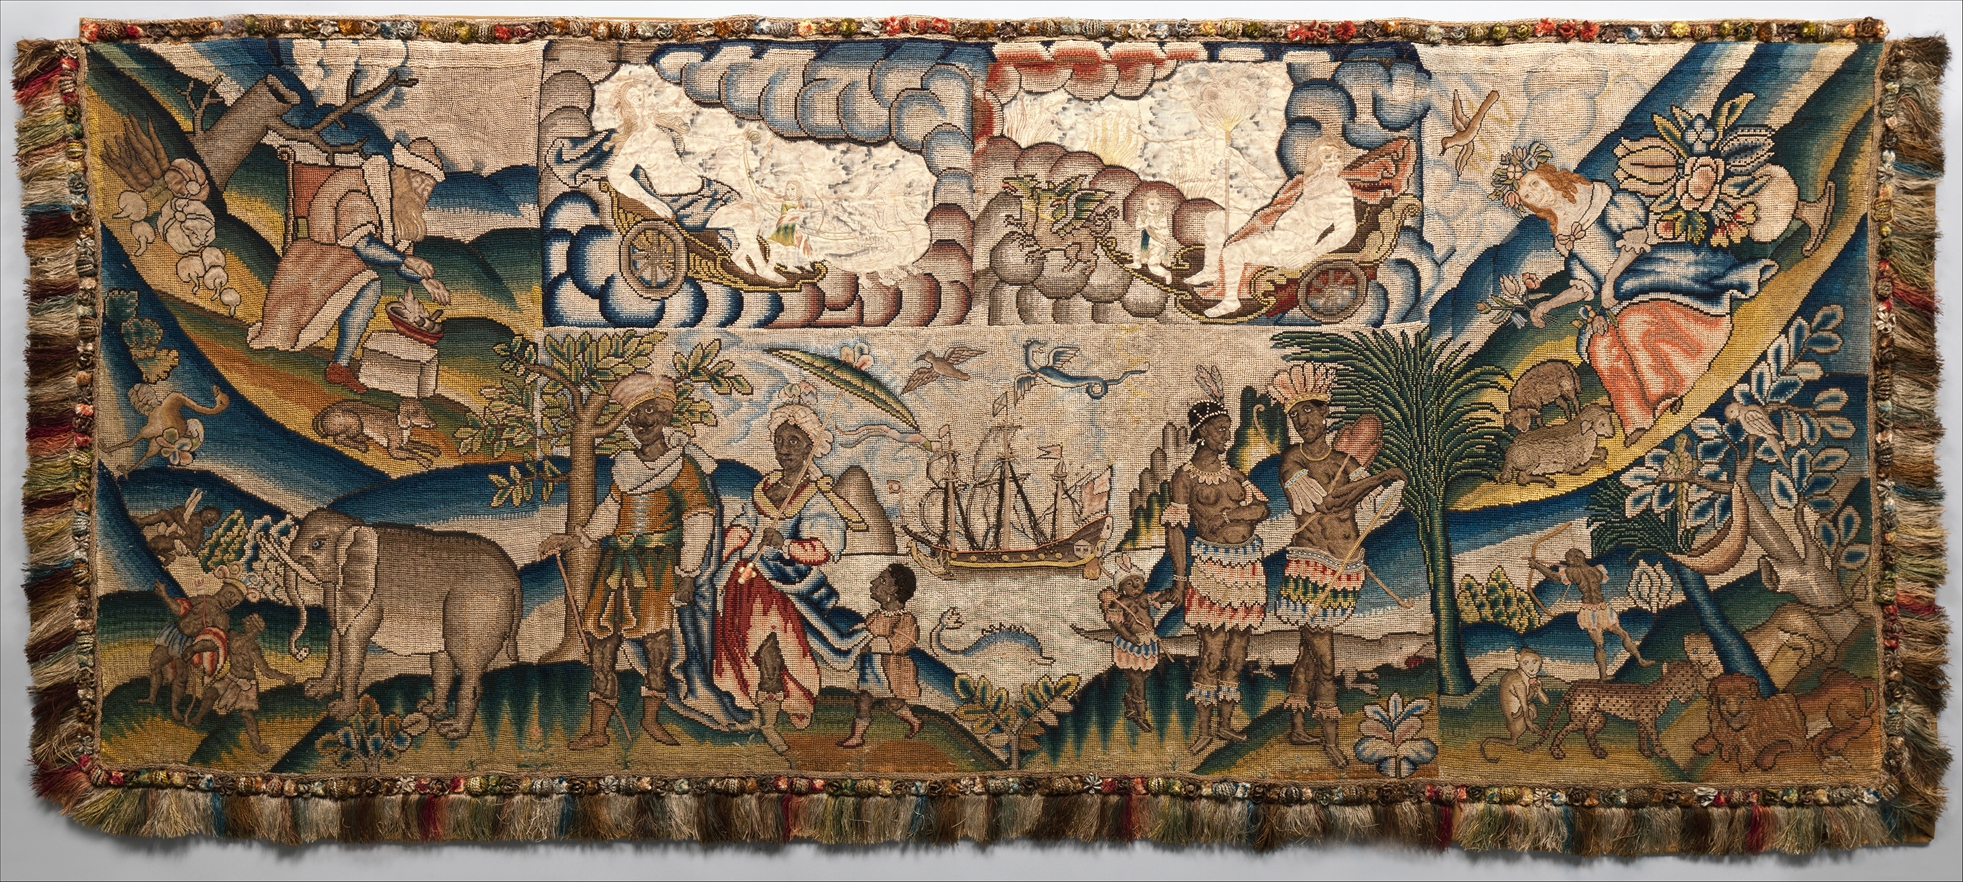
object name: panel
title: Panel from a table carpet showing the Four Continents, the Seasons, and Four Planets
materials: linen, metal, parchment, silk, thread, wool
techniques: embroidery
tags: birds,children,men,women,dogs,elephants,lions,monkeys,ships